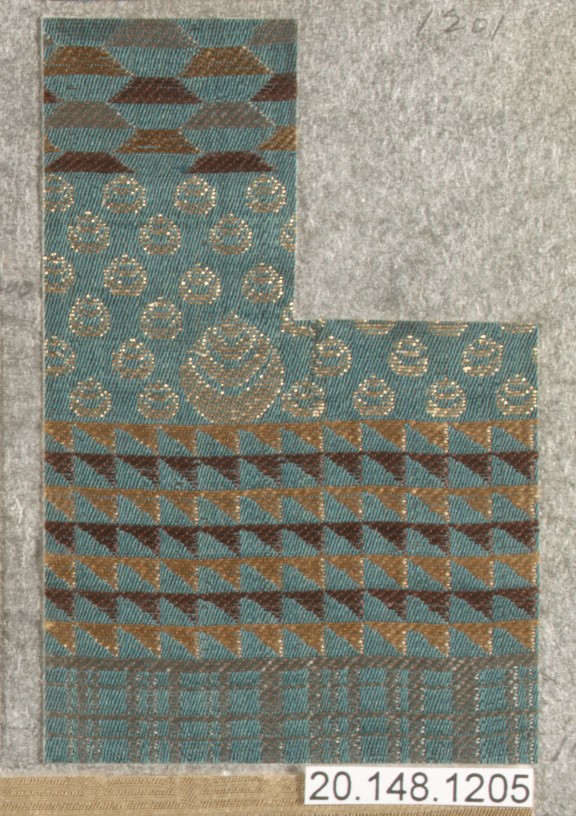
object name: piece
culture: japanese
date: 1701-1800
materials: silk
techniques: compound weave